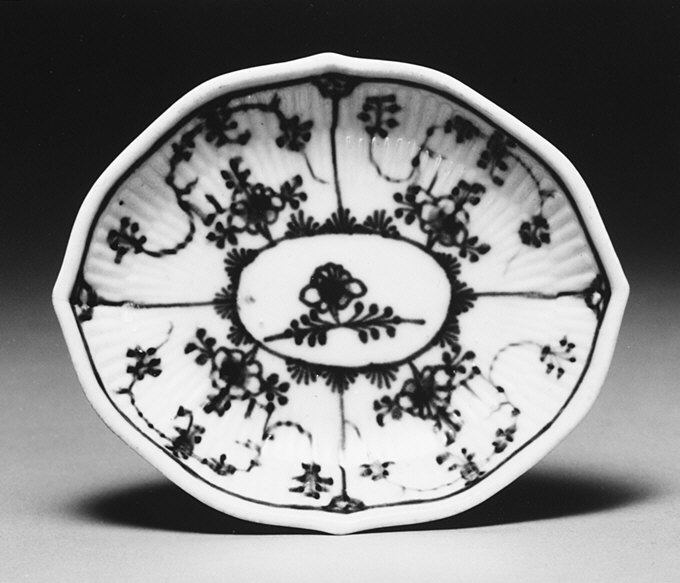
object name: spoon tray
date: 1701-1800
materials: hard paste porcelain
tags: flowers